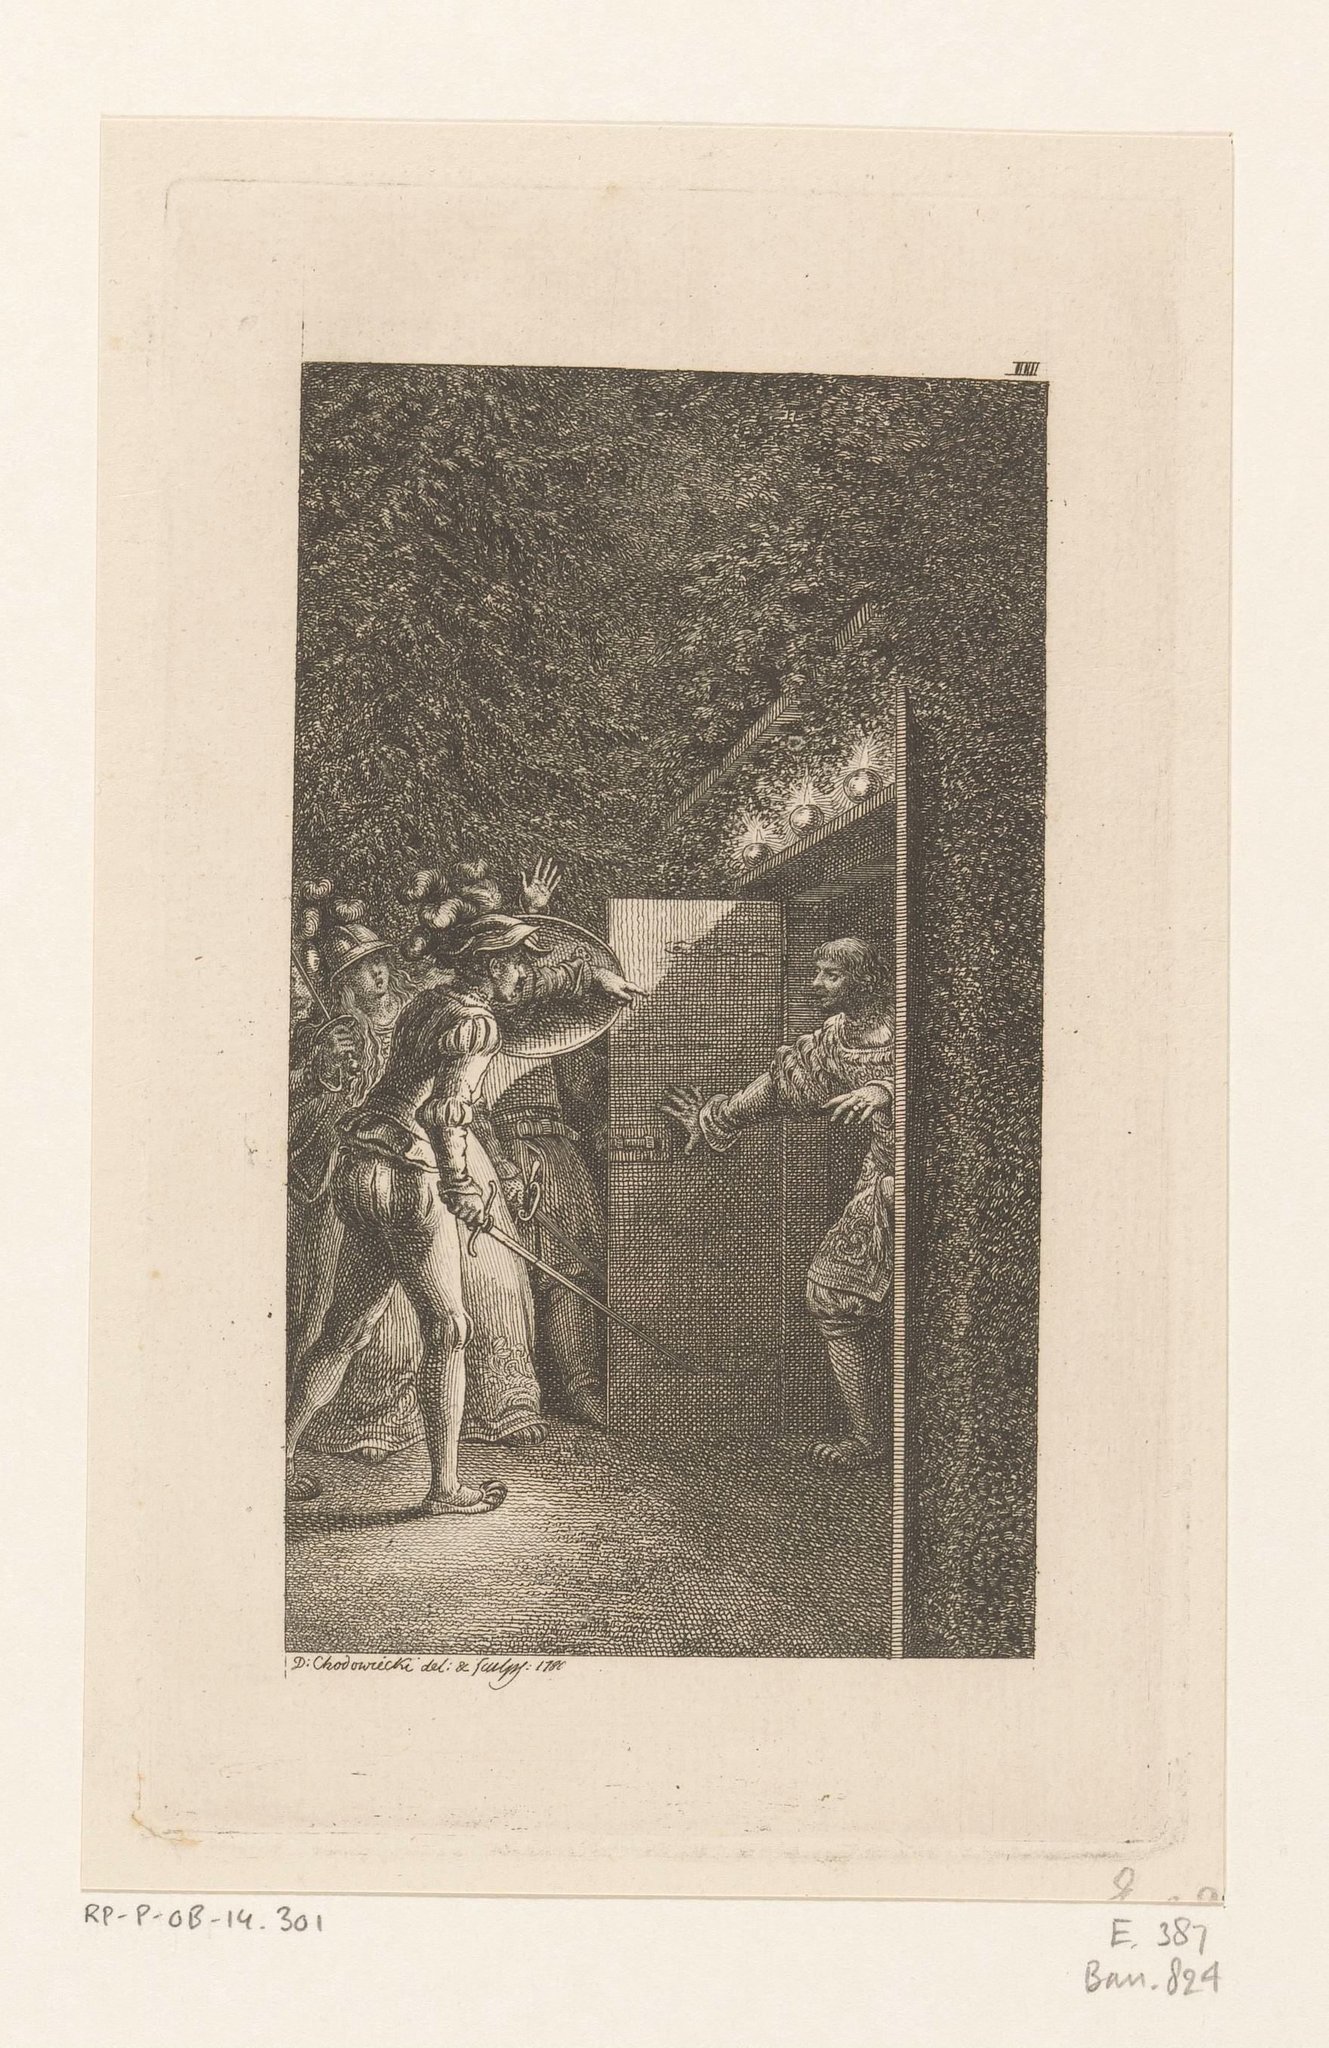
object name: print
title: Rolf Krage verschijnt ongewapend aan de deur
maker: daniel nikolaus chodowiecki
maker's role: draughtsman, print maker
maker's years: 1726-1801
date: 1781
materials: paper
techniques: etching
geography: berlin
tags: copenhagen (city), protective weapons: shield, opening the door, night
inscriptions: collector's mark: Lugt 2228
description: Prent gebruikt voor: Ewald, Johannes. Johannes Ewald's samtlige Skrifter. 4 dln. Kopenhagen: Christian Gotlob Proft, 1781-1791.